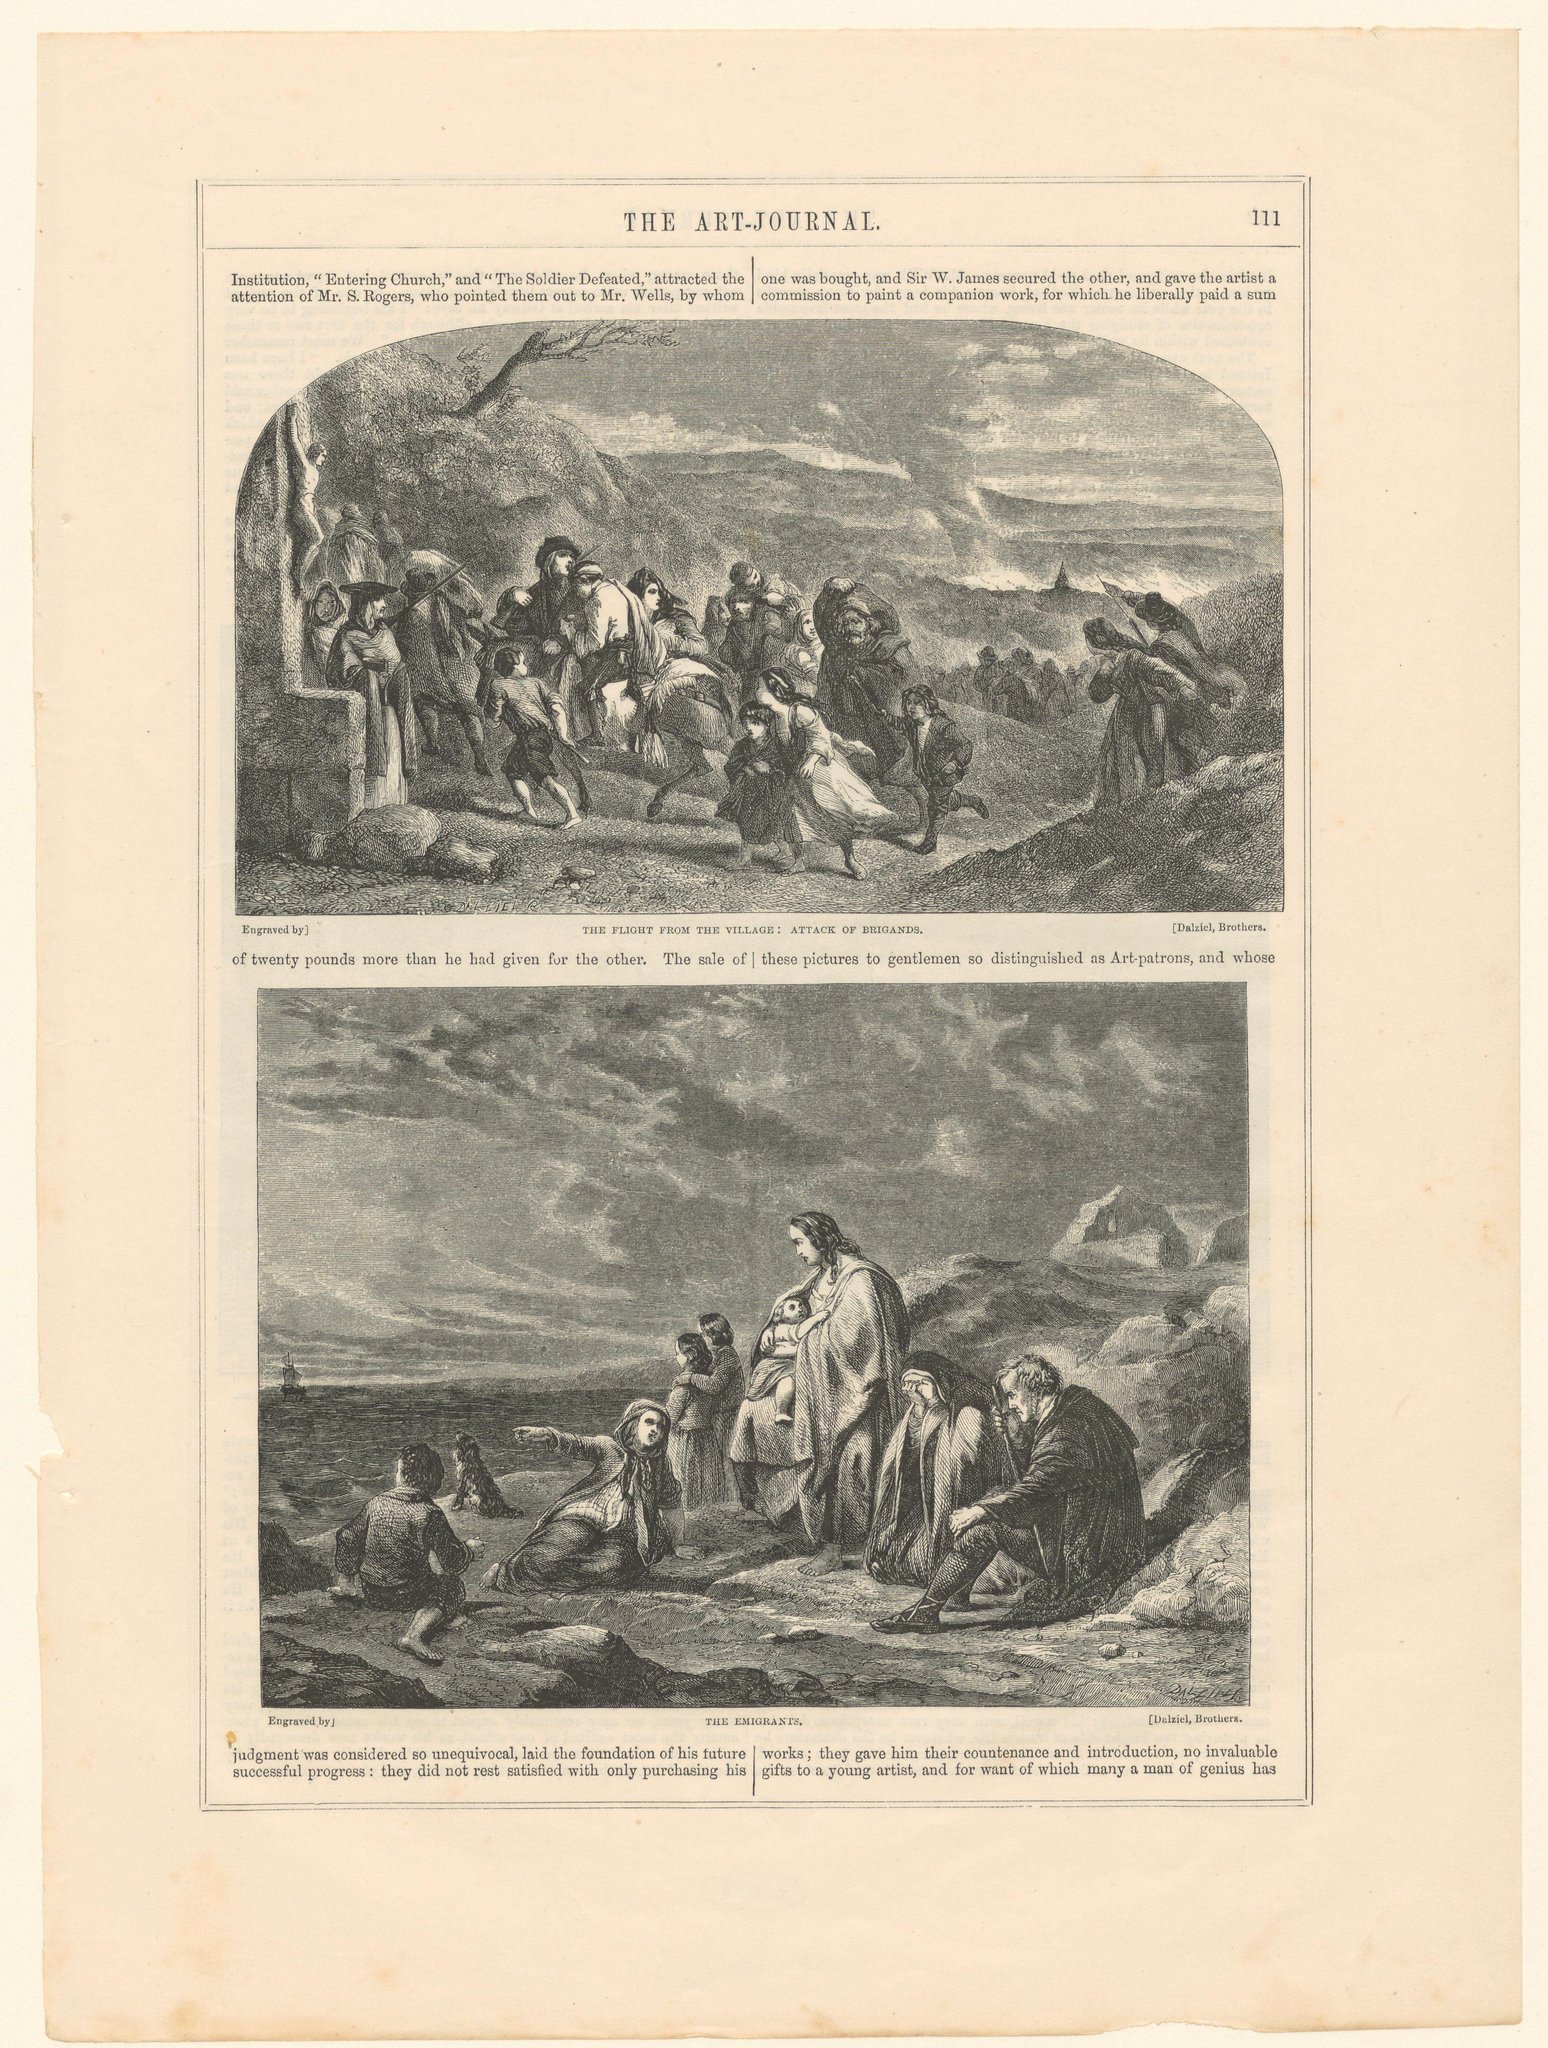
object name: print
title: The flight from the village: attack of the brigands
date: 1855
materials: paper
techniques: letterpress printing, engraving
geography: london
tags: emigration, flight, running away; pursuing, landscapes (+ landscape with figures, staffage)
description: Prent uit: The Art Journal 4 (1855), p. 111.